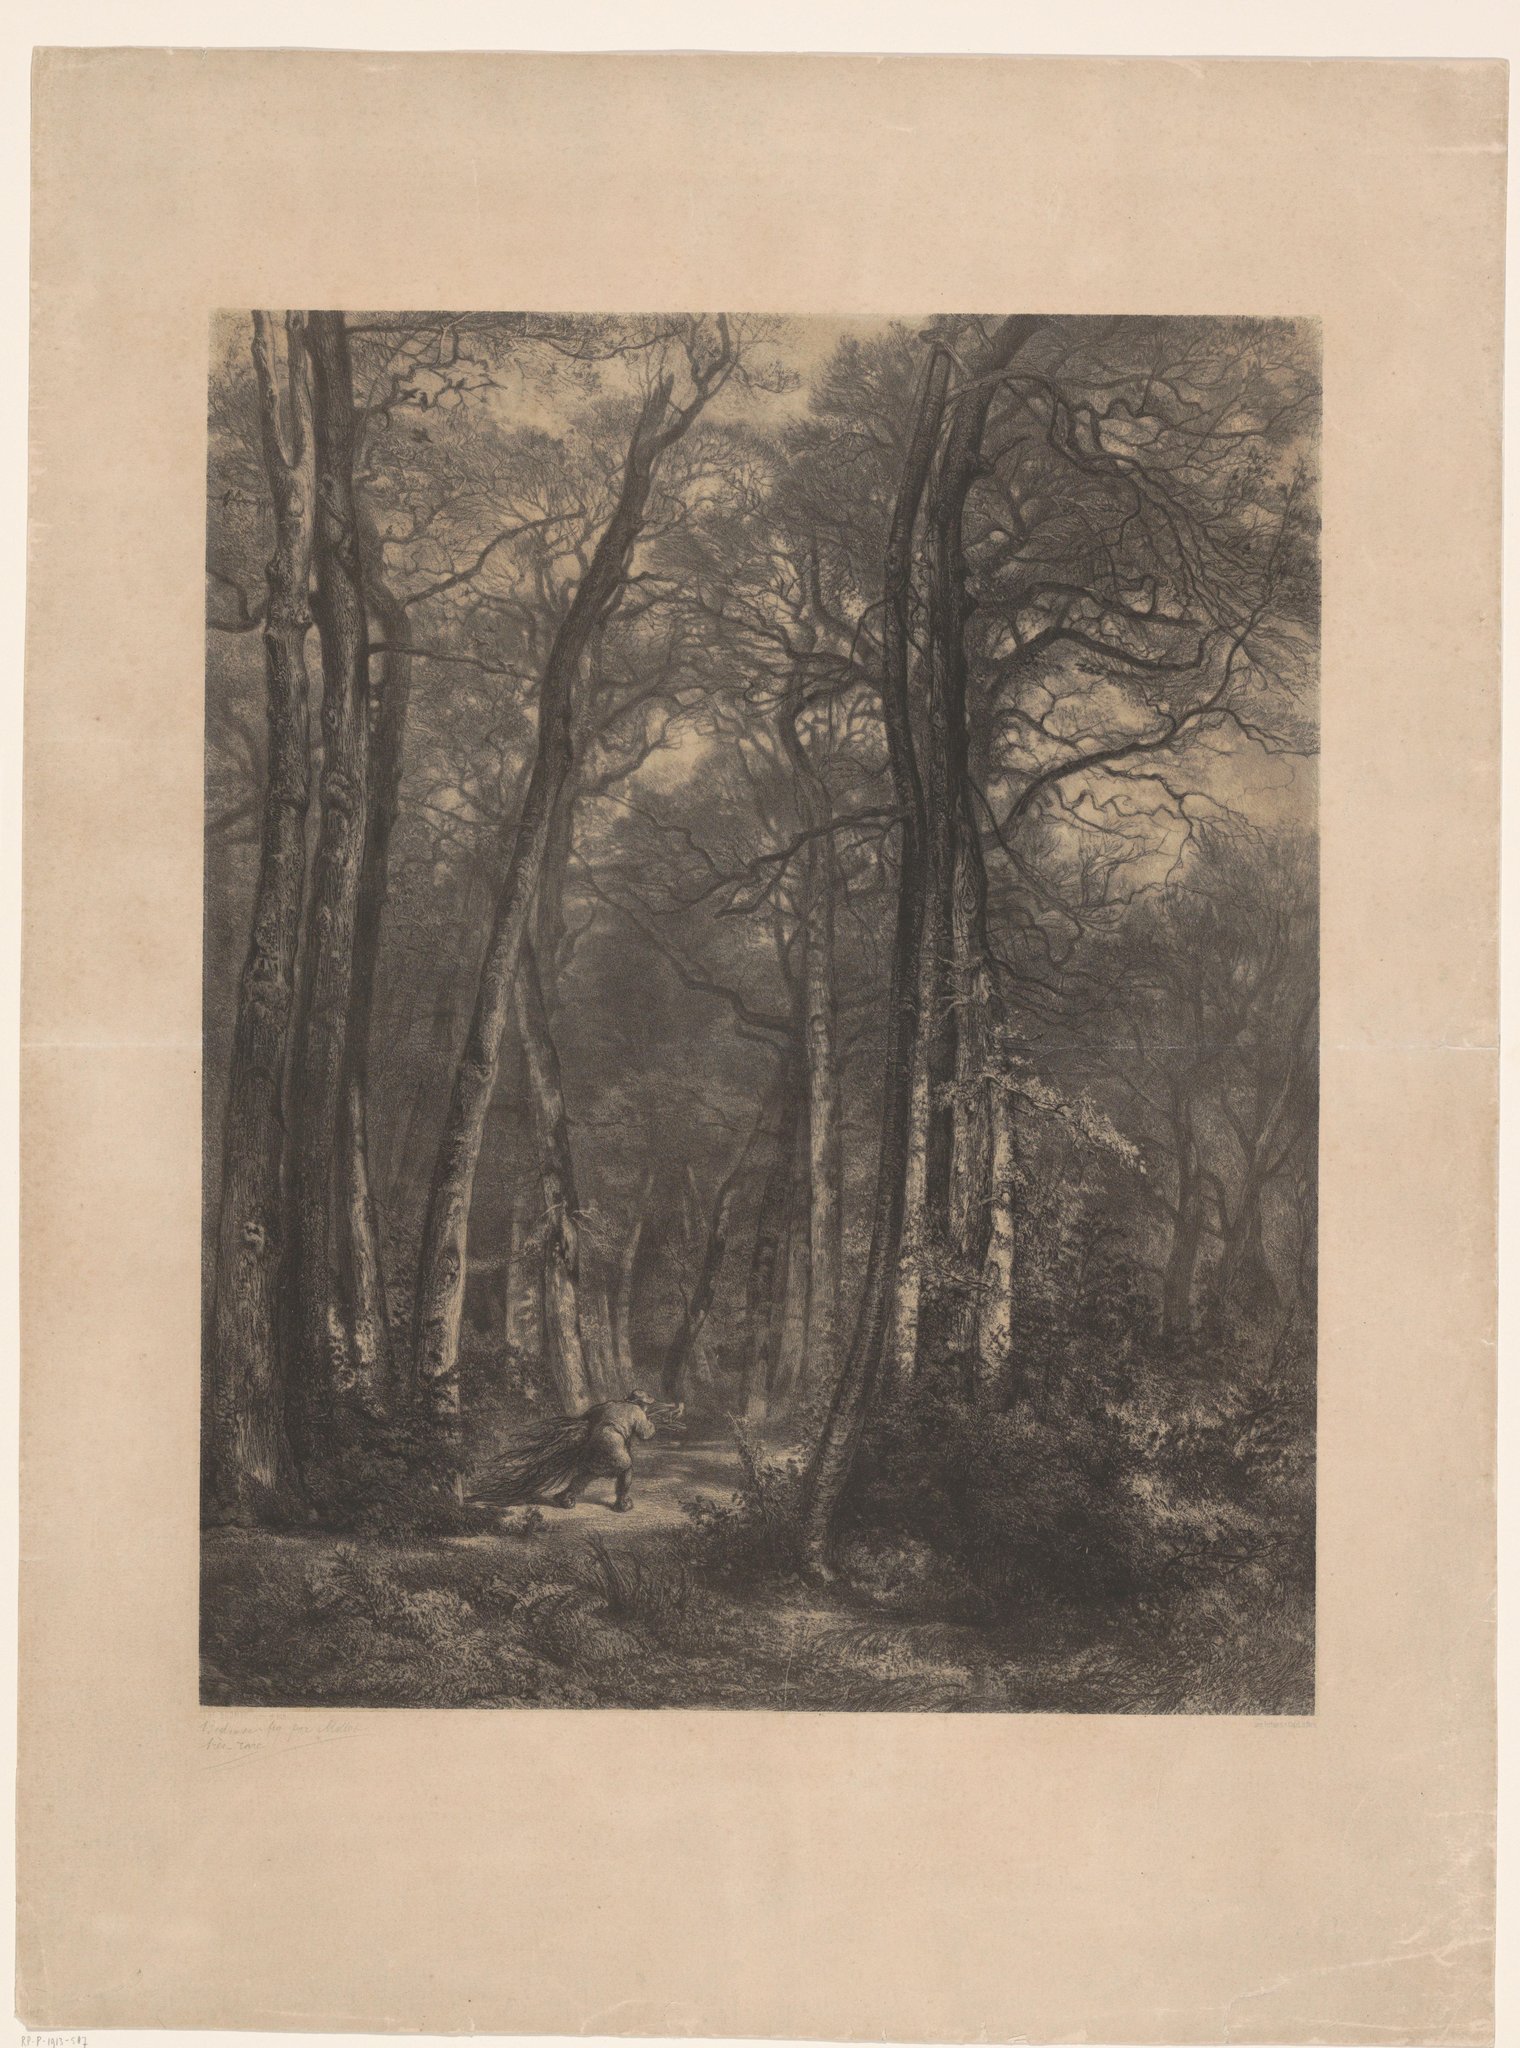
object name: print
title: Bos met houthakker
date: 1851-1865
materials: paper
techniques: lithograph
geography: paris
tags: woodcutting, woodcutter ~ forestry, forest, wood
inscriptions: collector's mark: Lugt 2233, inscription: ‘Bodmer fig par Millet/ très rare’